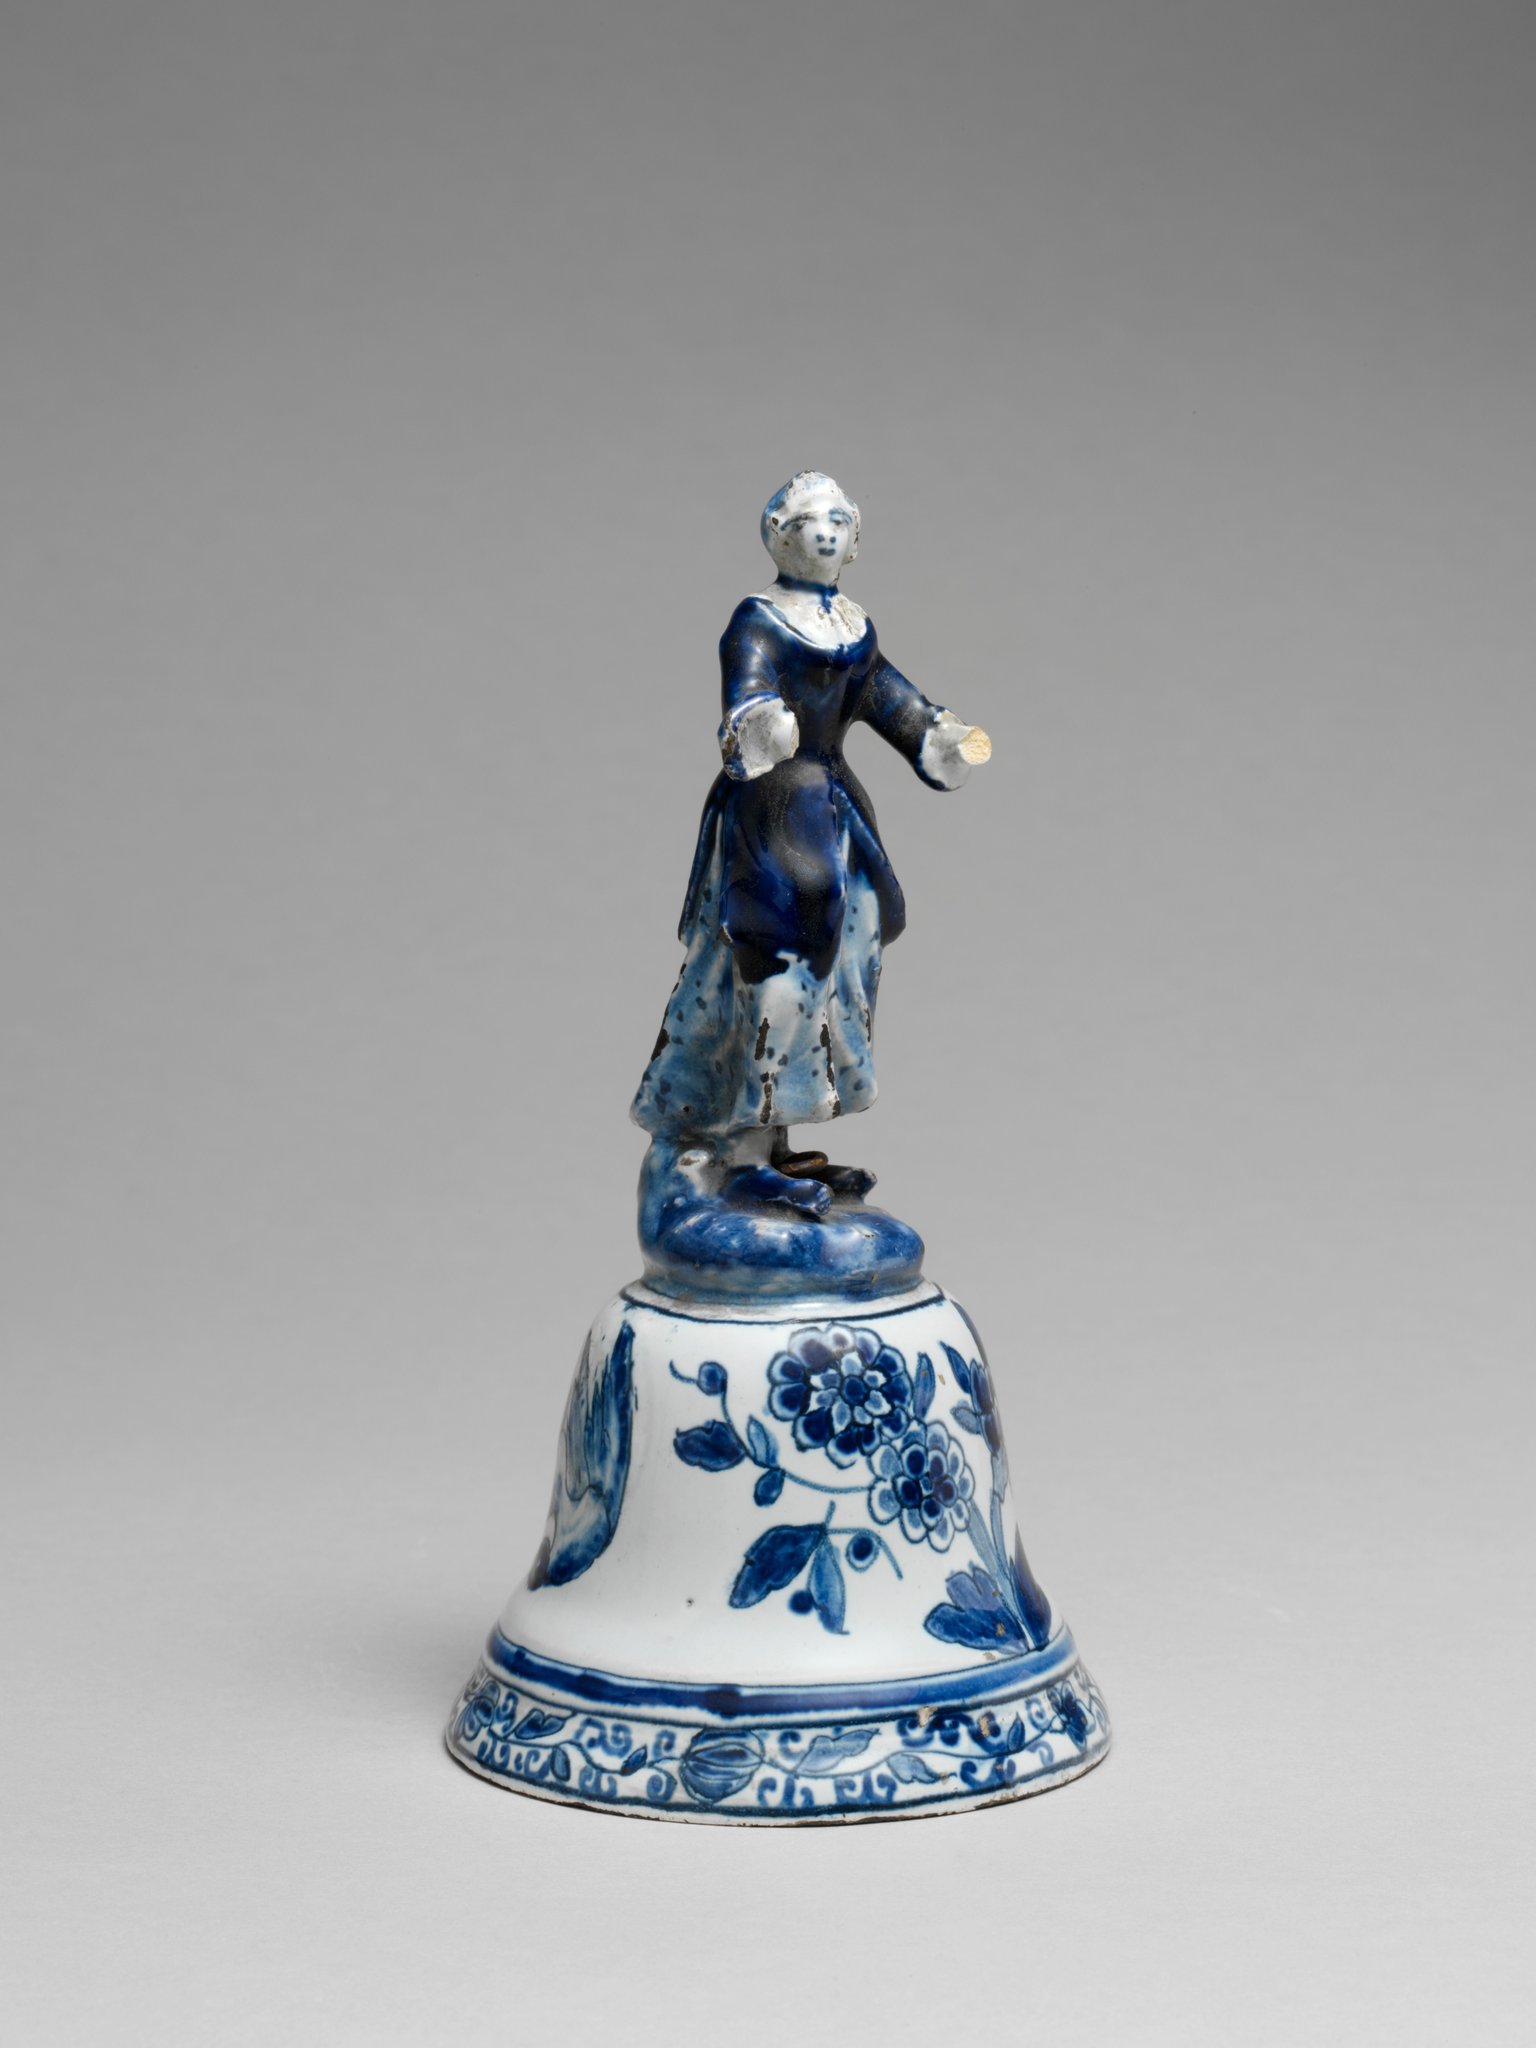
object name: handbell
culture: dutch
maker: johannes harlees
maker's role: maker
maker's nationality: dutch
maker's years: 1770-1795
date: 1770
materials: earthenware, tin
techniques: enamel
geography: netherlands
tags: women